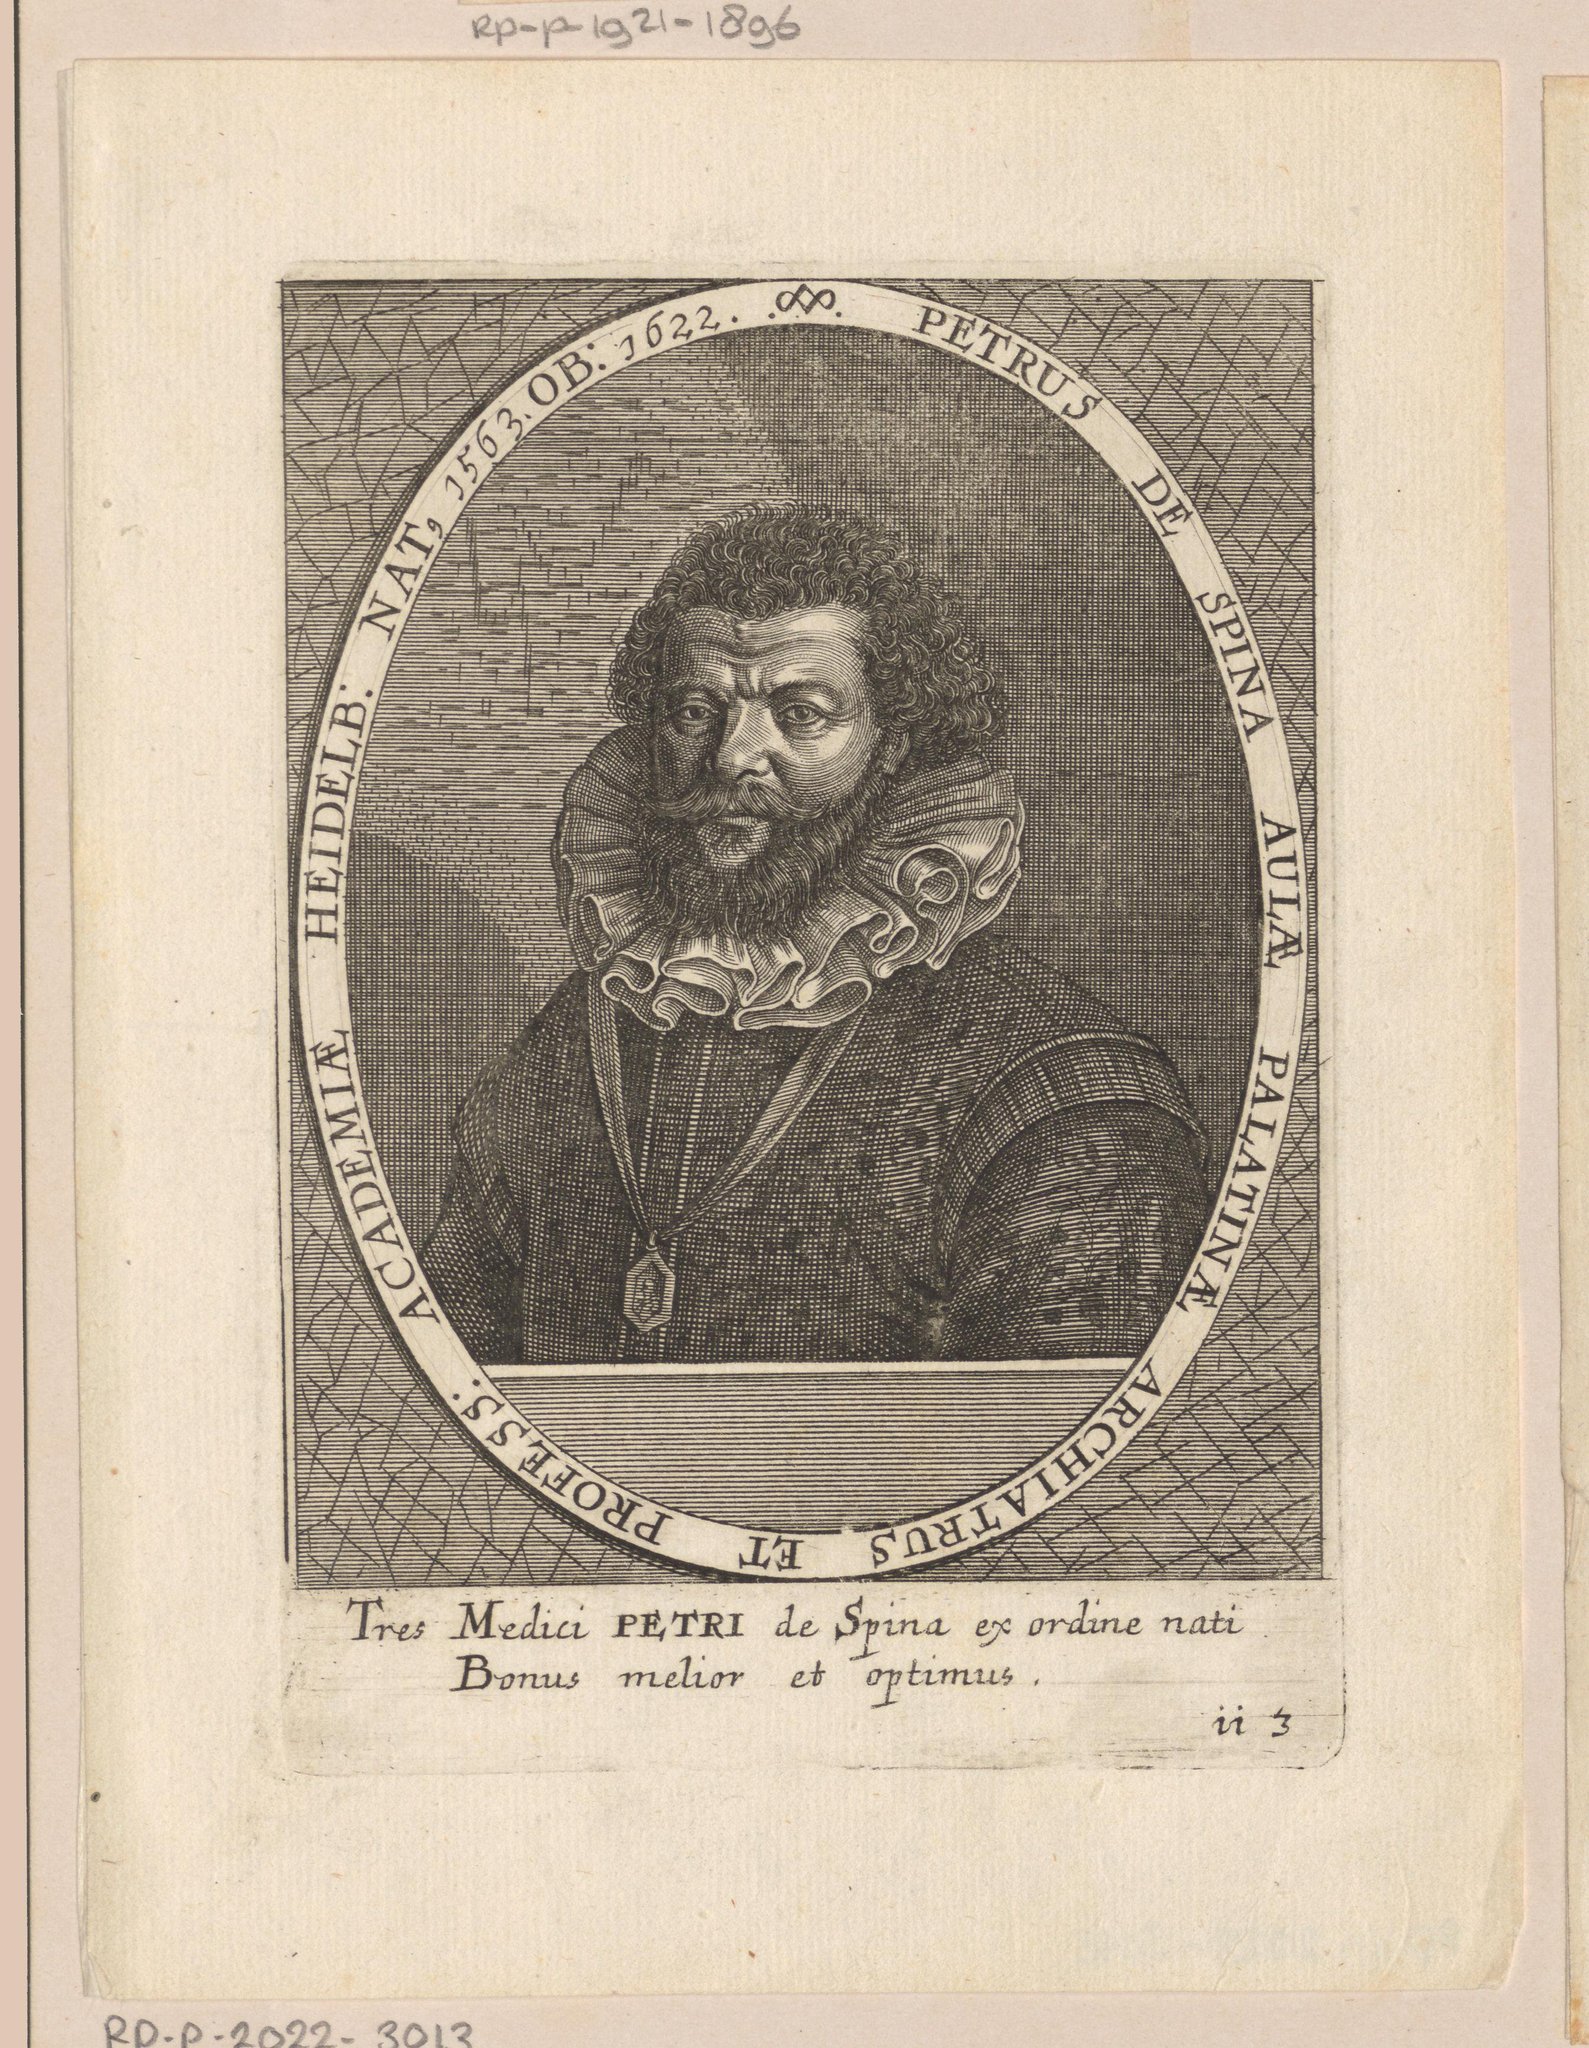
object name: print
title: Portret van Peter Spina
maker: Anonymous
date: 1650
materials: paper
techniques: engraving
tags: historical persons, physician, doctor (+ portrait of scholar, scientist)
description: Prent waarschijnlijk uit: Boissard, Jean Jacques. Bibliotheca chalcographica. Frankfurt am Main: Johannes Ammon, 1650. Ook gebruikt in de editie uit 1669.